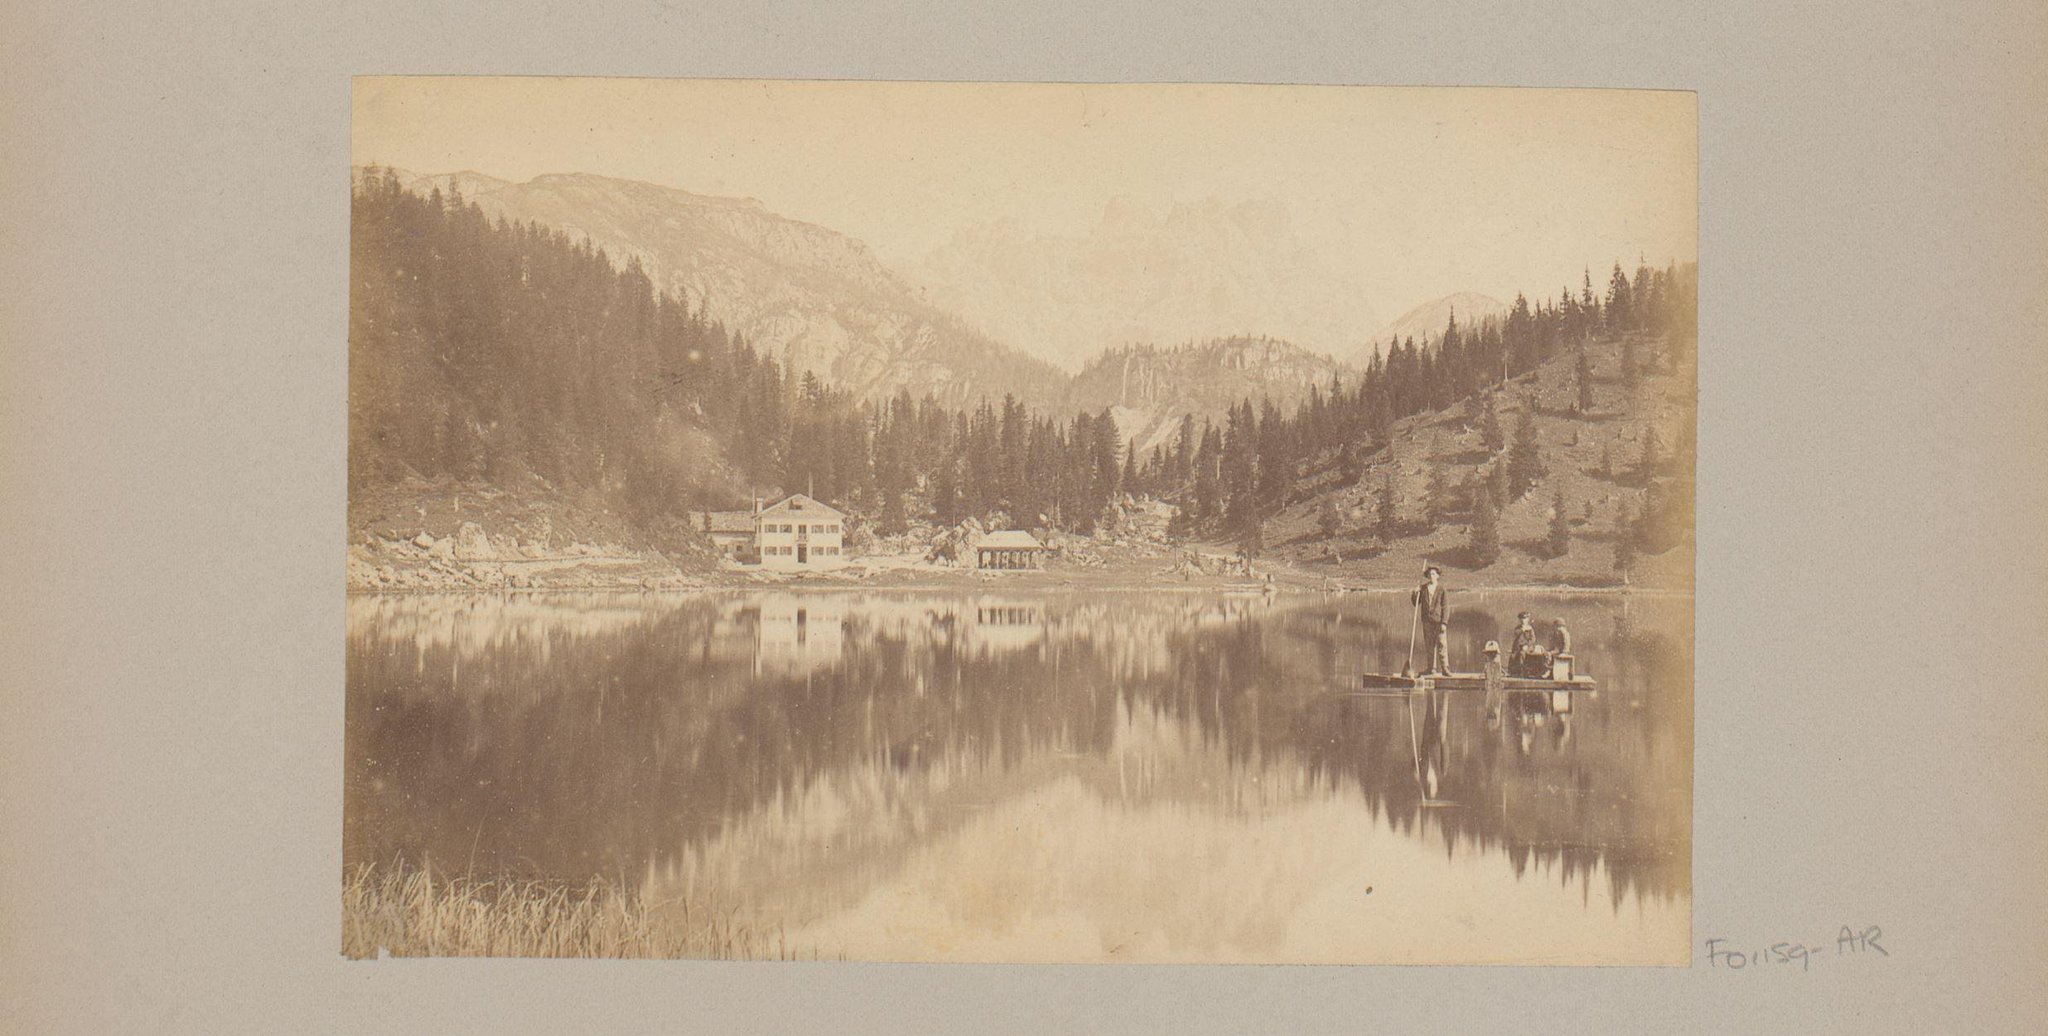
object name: photograph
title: Meer in de Alpen, vermoedelijk Duitsland, met een man en kinderen op een vlot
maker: Anonymous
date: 1880-1900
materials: photographic support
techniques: albumen print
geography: germany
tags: lake, raft, mountains, germany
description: Onderdeel van Reisalbum met opnames van bezienswaardigheden in Zweden, Noorwegen, Denemarken, Beieren, Milaan en Parijs.